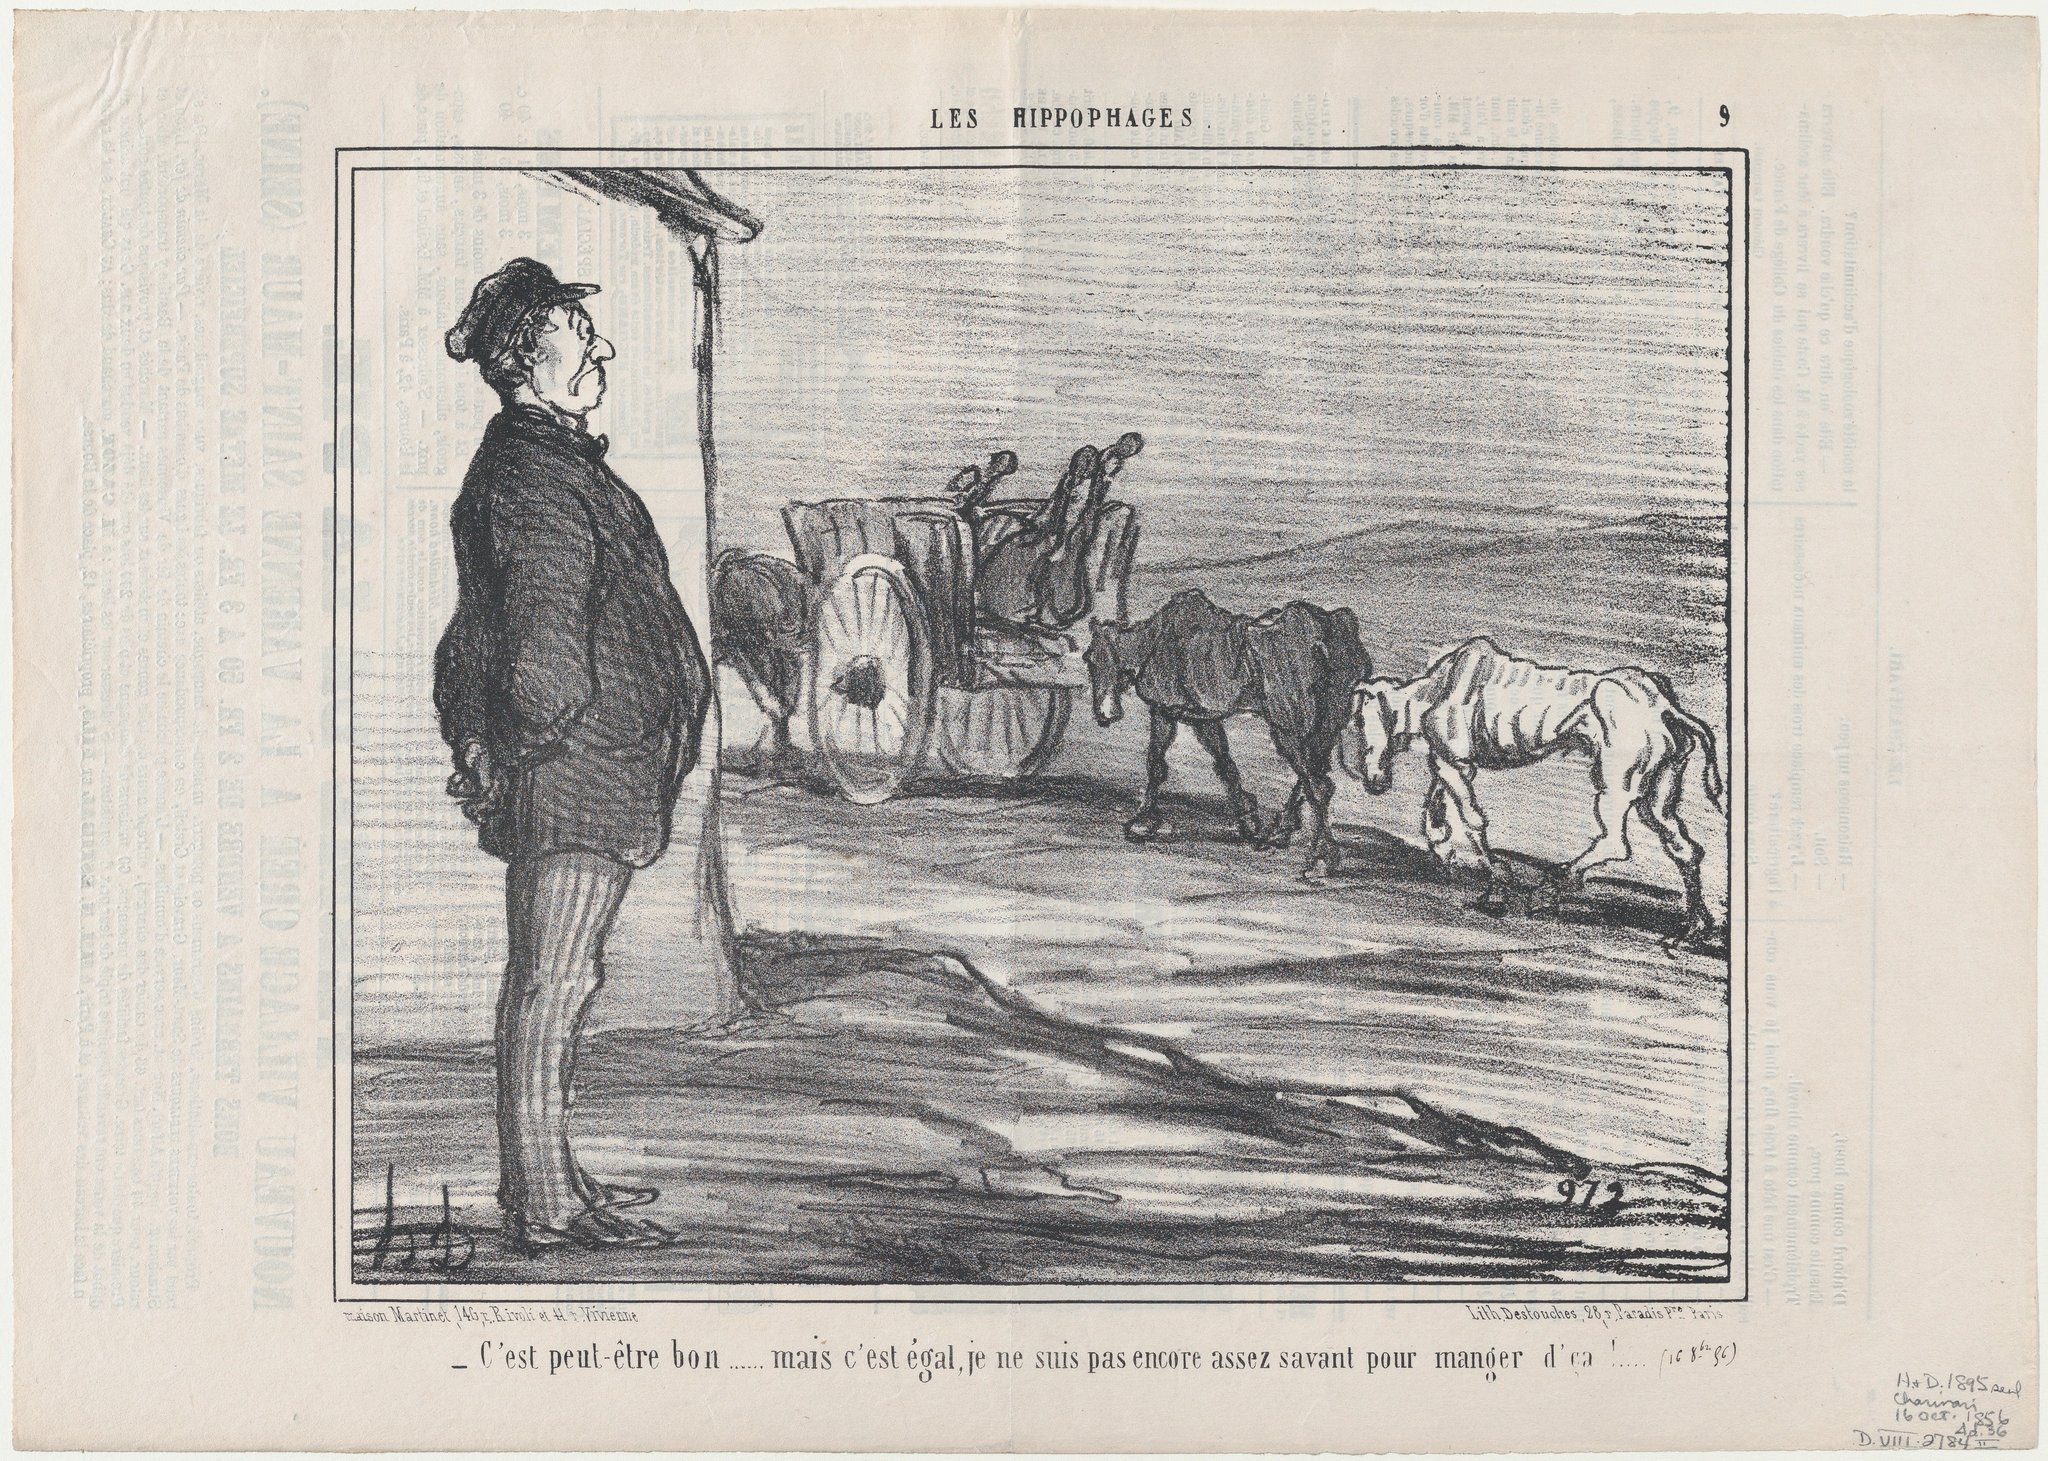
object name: print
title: C'est peut-être bon...mais c'est égal..., from Les Hippophages, published in Le Charivari, October 23, 1856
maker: honoré daumier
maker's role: artist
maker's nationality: french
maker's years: 1808-1879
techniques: lithograph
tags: satire,men,horses,wagons